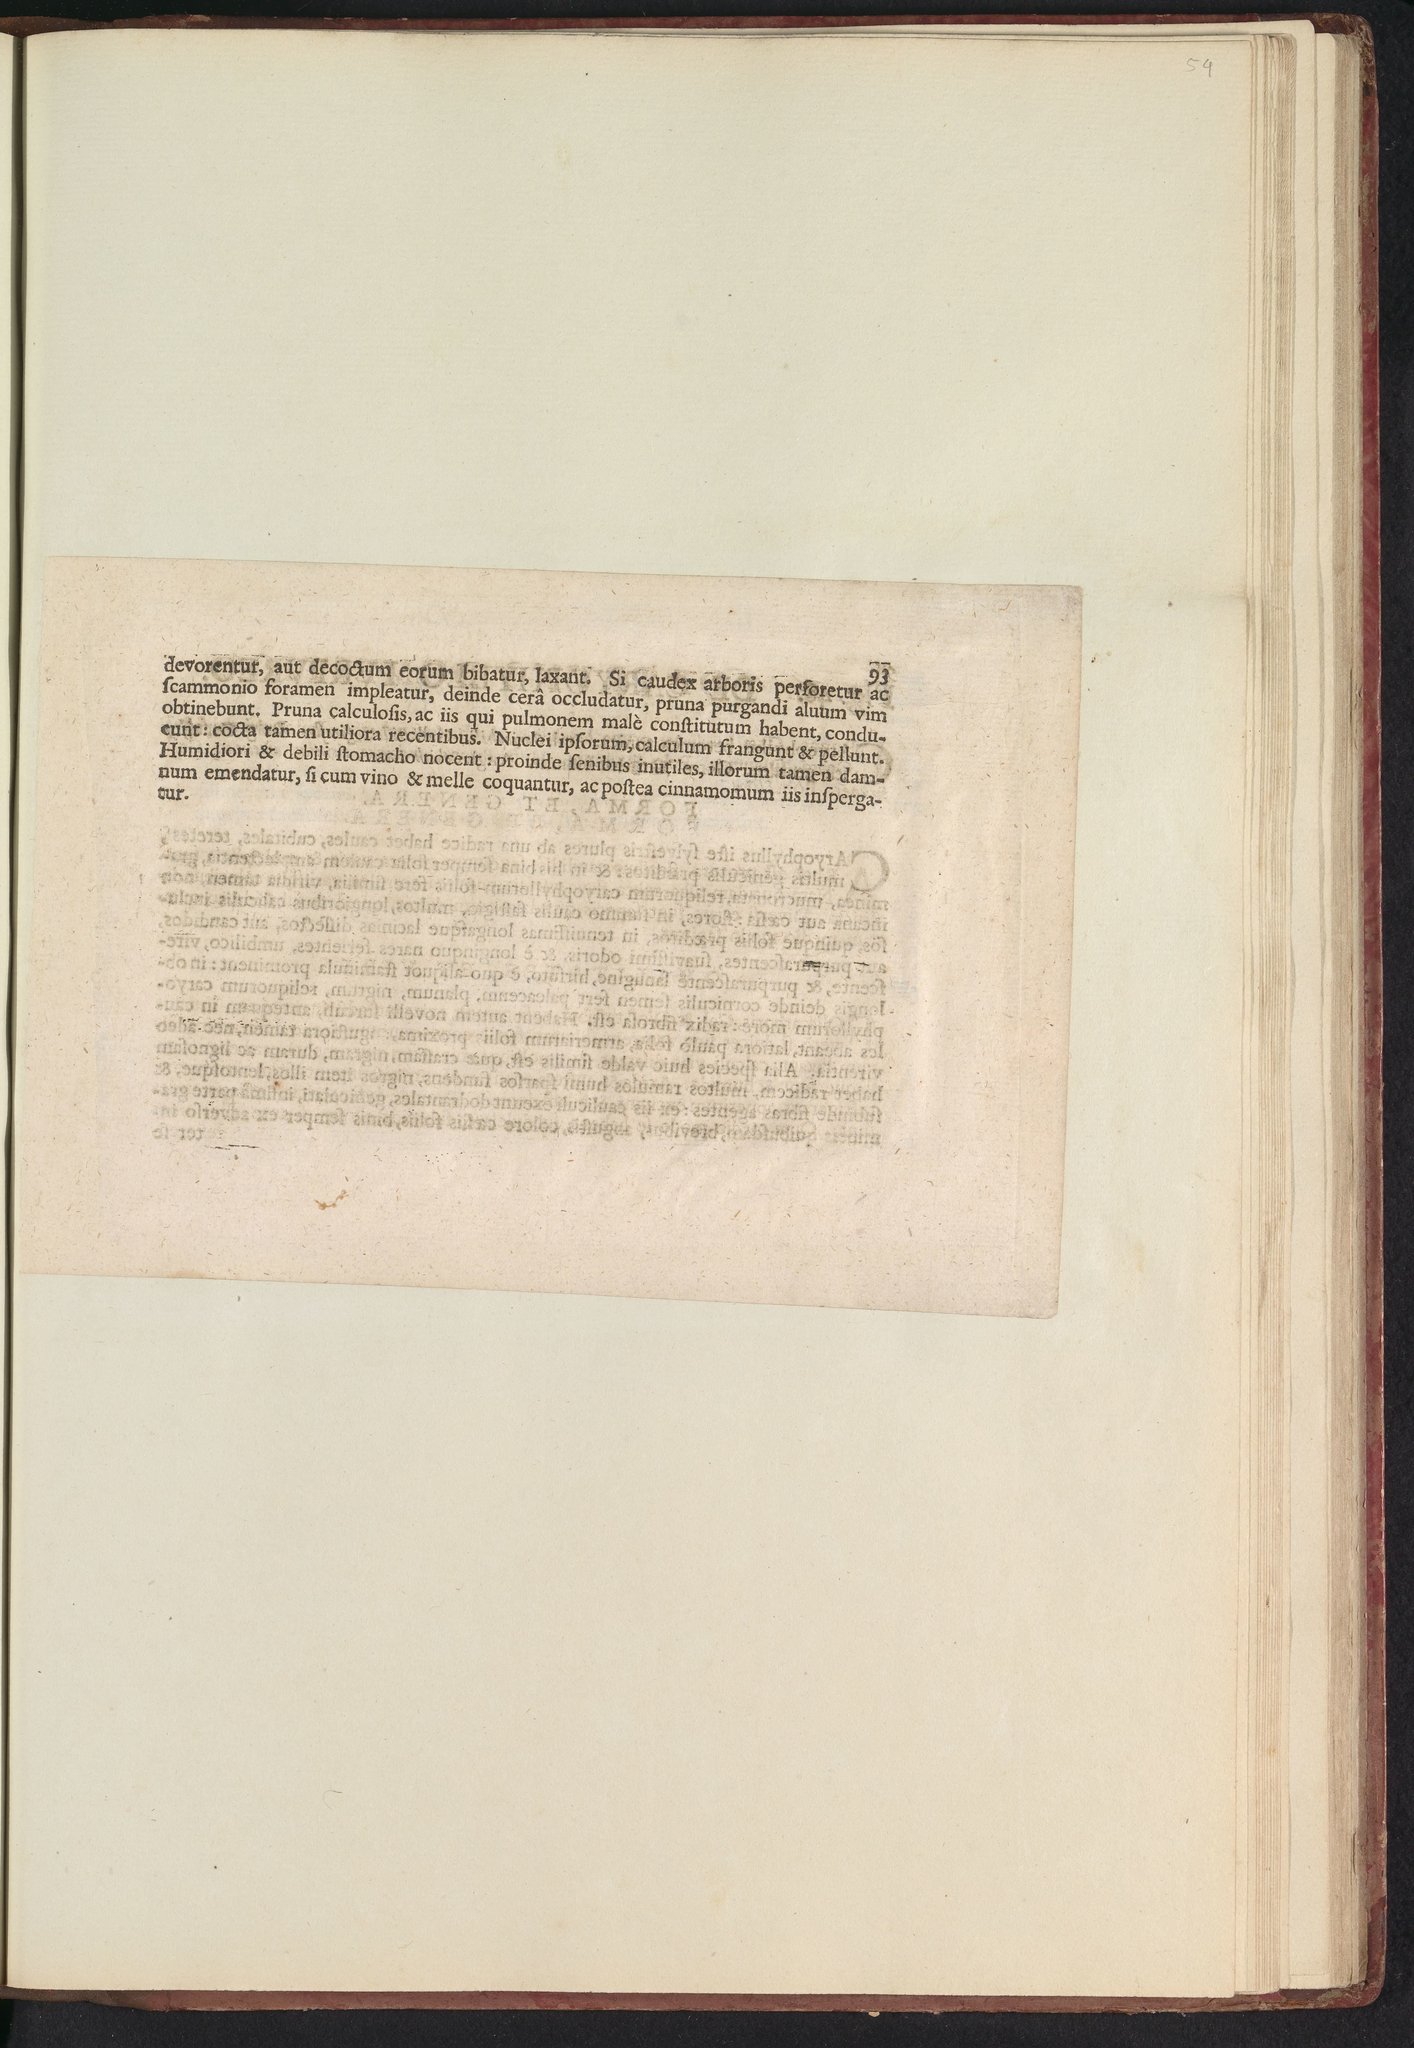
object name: text sheet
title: Fig. 47 'De Prvno Domestica' in De Boodts herbarium van 1640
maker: anselmus boëtius de boodt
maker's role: draughtsman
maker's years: 1550-1632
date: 1640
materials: ink, paper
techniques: letterpress printing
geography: bruges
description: Beschrijving bij Fig. 47 op p. 93 in: Anselmi Boëtii de Boot I.C. Brugensis & Rodolphi II. Imp. Roman. medici a cubiculis Florum, Herbarum, ac fructuum selectiorum icones, & vires pleraeque hactenus ignotæ. Onderdeel van het album met bladen en platen uit De Boodts herbarium van 1640. Het twaalfde van twaalf albums met aquarellen van dieren, vogels en planten bekend rond 1600, gemaakt in opdracht van keizer Rudolf II.